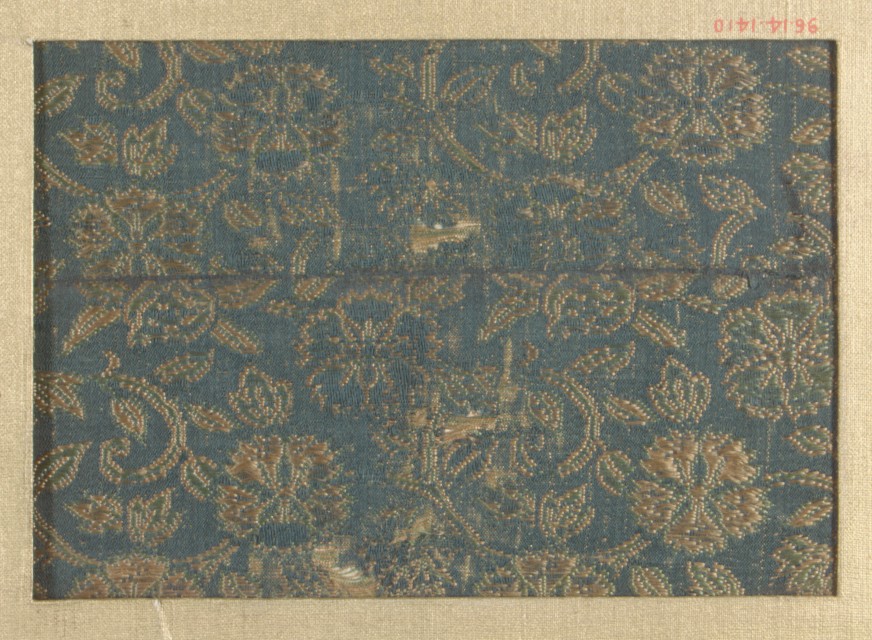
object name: piece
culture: japanese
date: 1701-1900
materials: silk